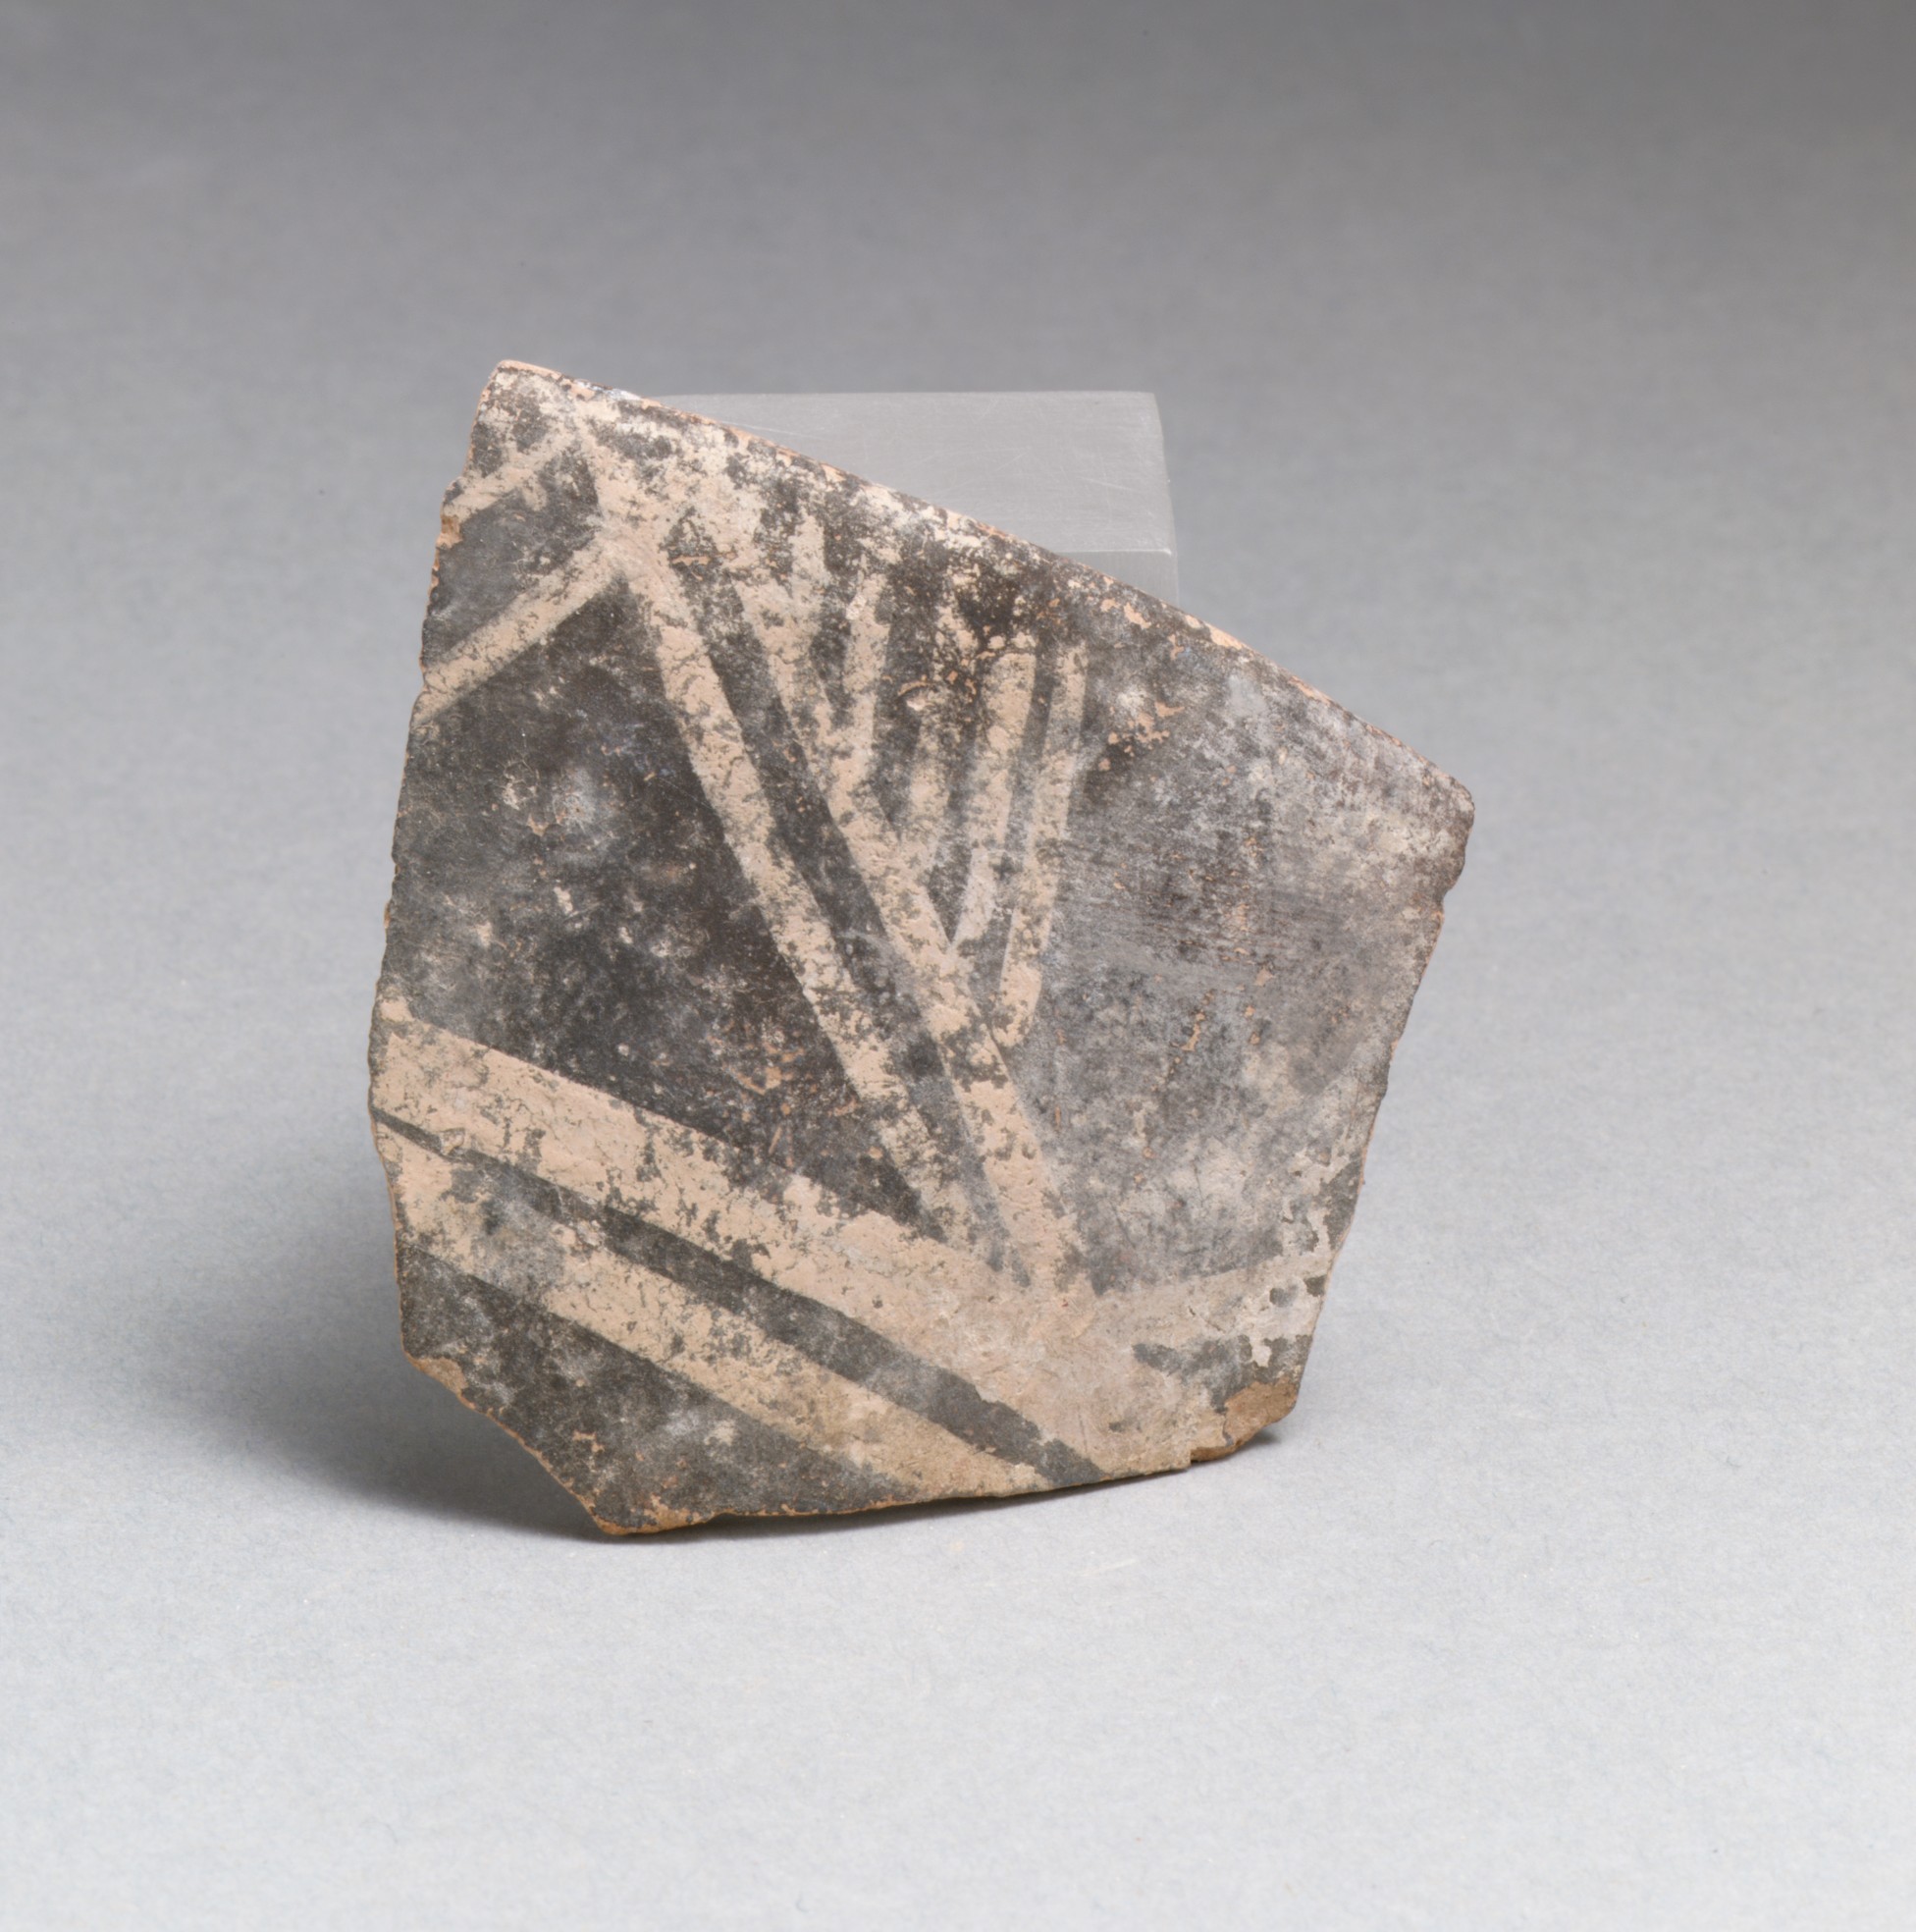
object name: vase fragment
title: Terracotta rim from a cup with triangles and parallel vertical lines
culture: minoan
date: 2300-2100 BCE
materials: terracotta